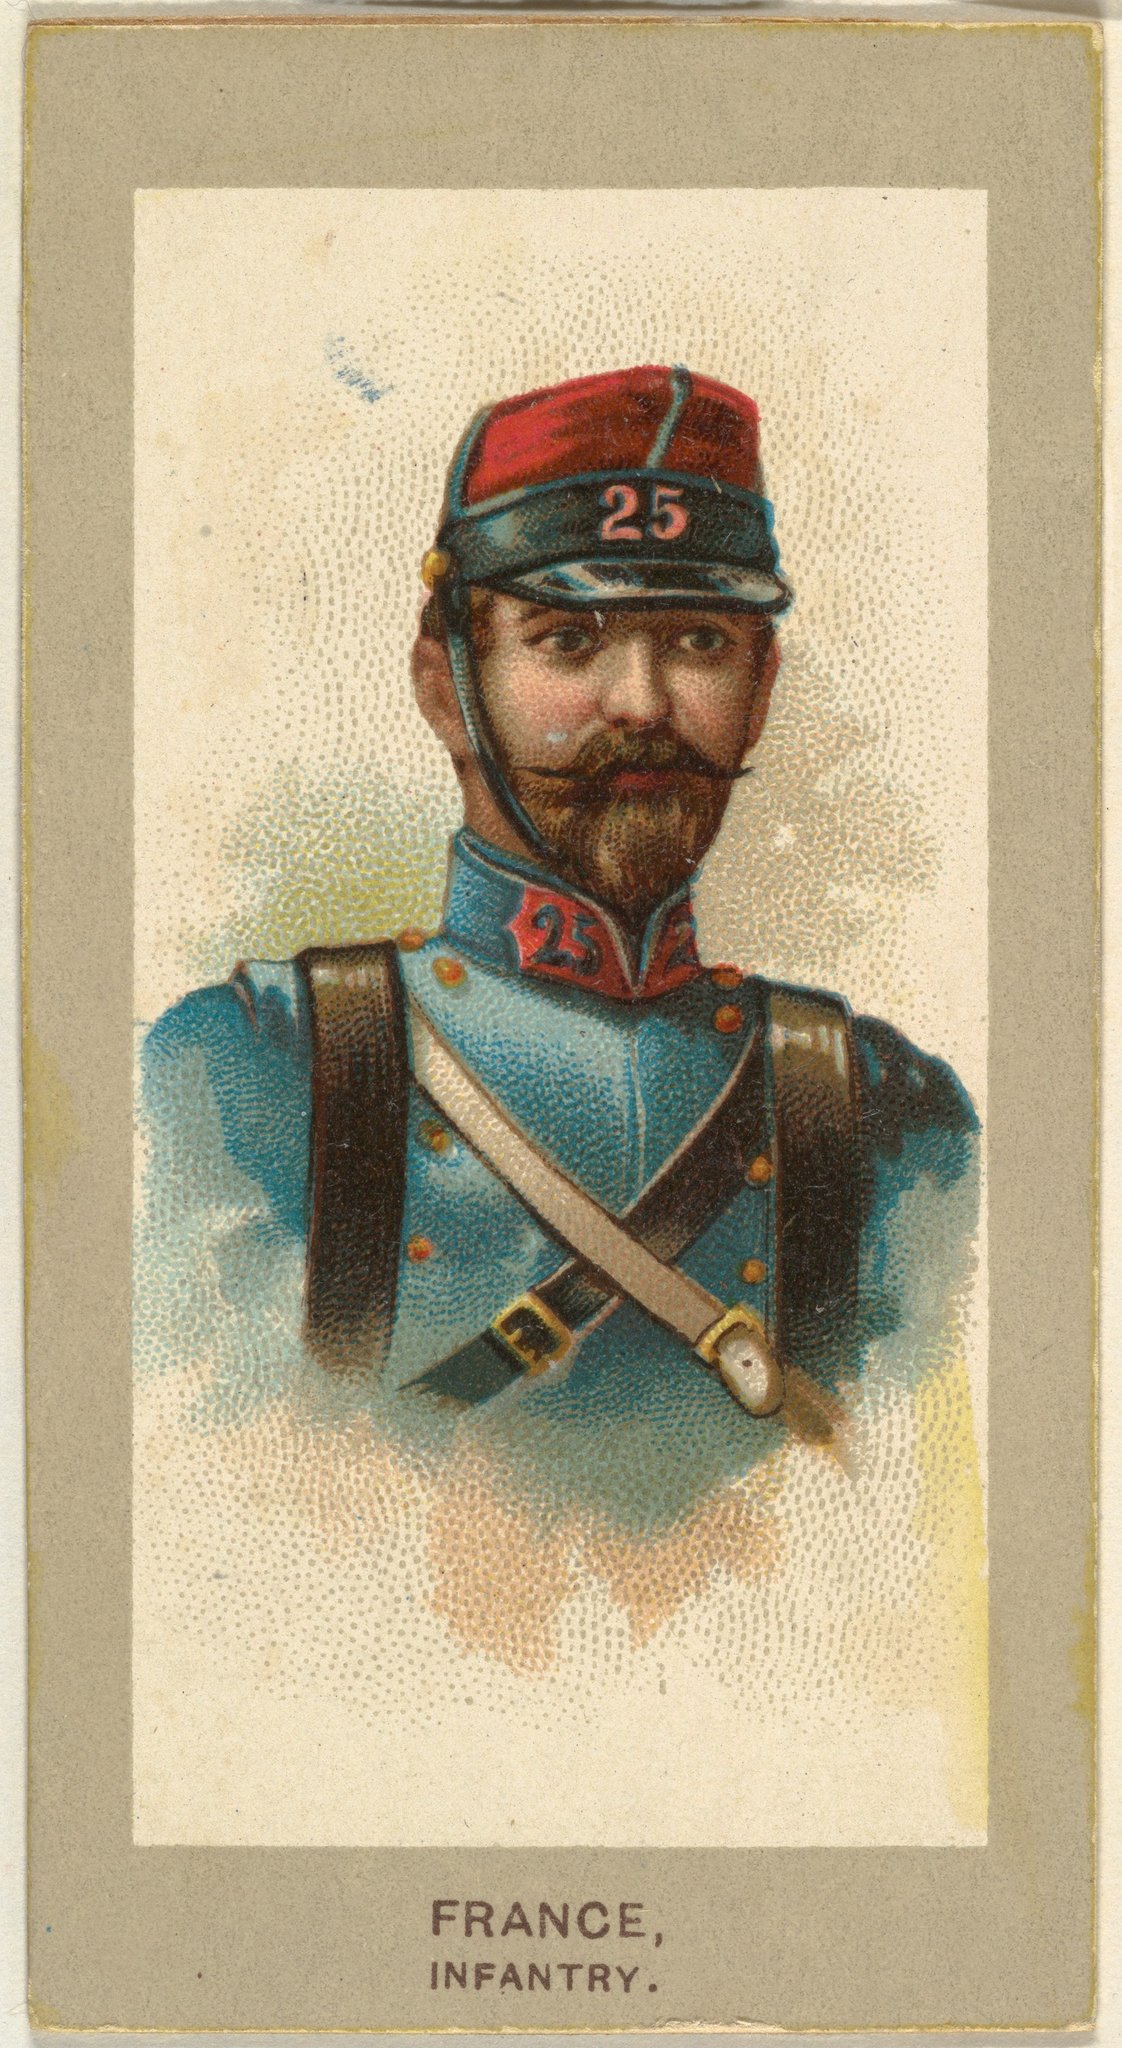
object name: print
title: Infantry, France, from the Military Uniforms series (T182) issued by Abdul Cigarettes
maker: abdul cigarettes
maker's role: publisher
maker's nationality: american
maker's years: 1881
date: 1881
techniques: color lithograph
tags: uniforms,military,men